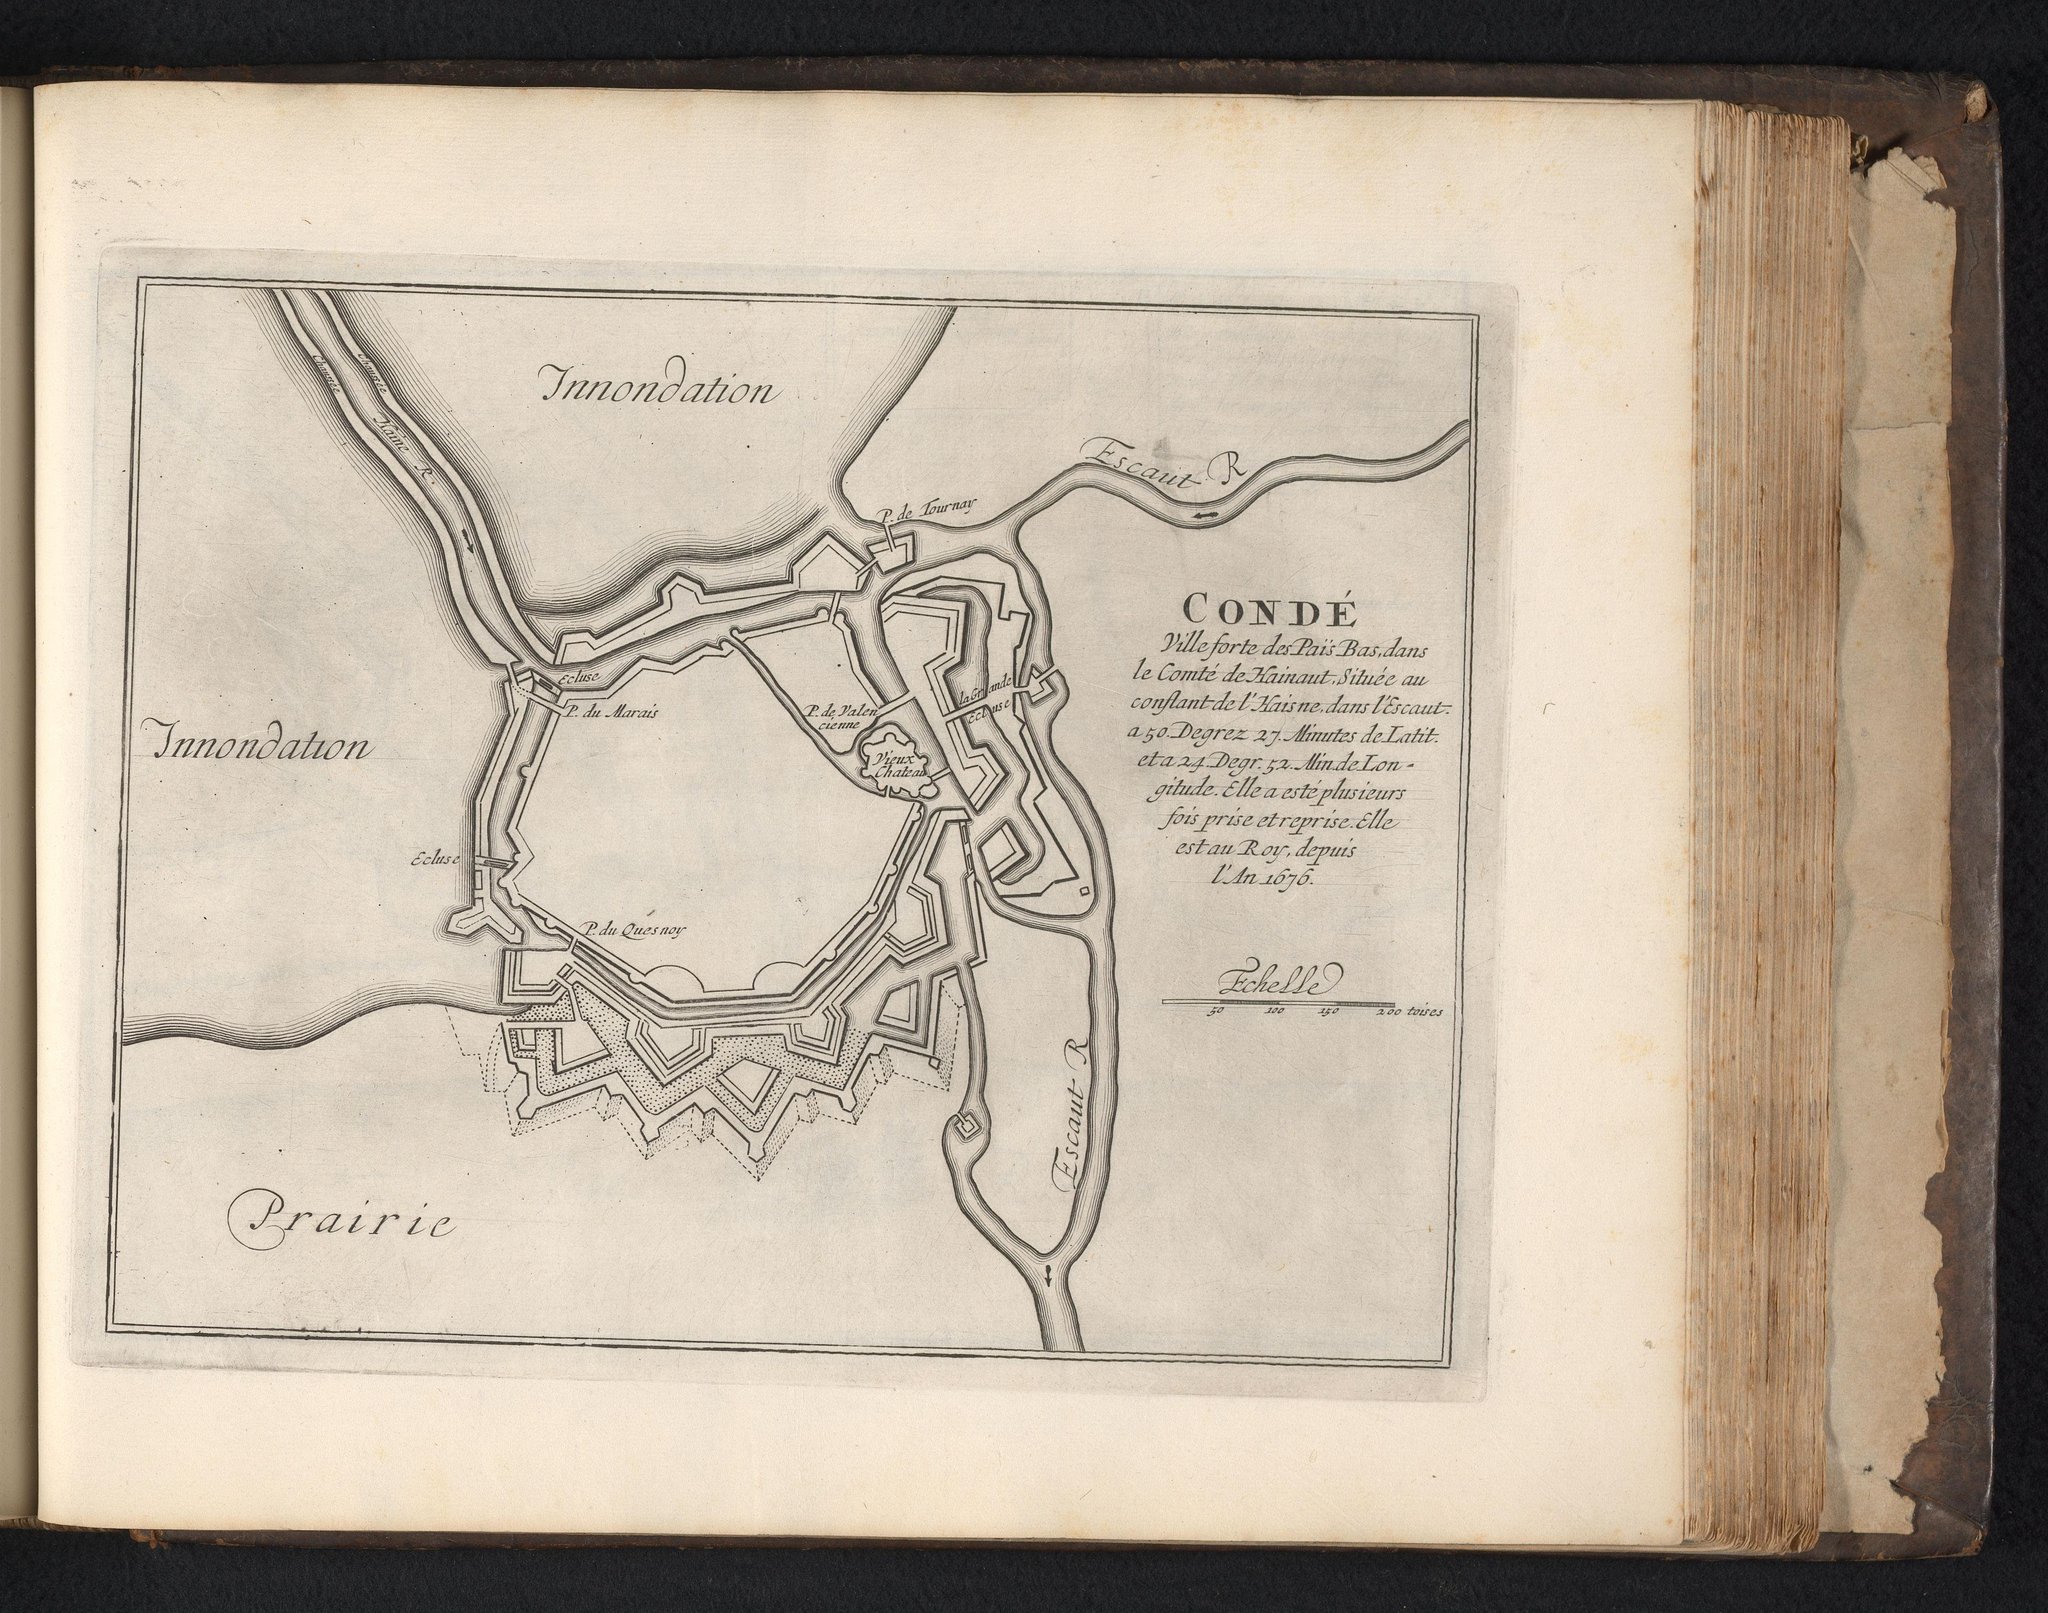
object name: print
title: Plattegrond van Condé-sur-l'Escaut, ca. 1695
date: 1695-1697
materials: paper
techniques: etching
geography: france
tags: fortress, maps of cities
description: Plattegrond van de versterkingen om de stad Condé-sur-l'Escaut. Onderdeel van het achtste deel (1697) van het prentwerk waarin gebundeld zijn de acht delen van Les forces de l'Europe uitgegeven tussen 1693-1697. Het prentwerk bestaat uit 175 platen met plannen (afkomstig van Sébastien Le Prestre, Seigneur de Vauban) van vermaarde sterke steden en vestingen in de Negenjarige Oorlog. Titel en opschriften in het Frans.